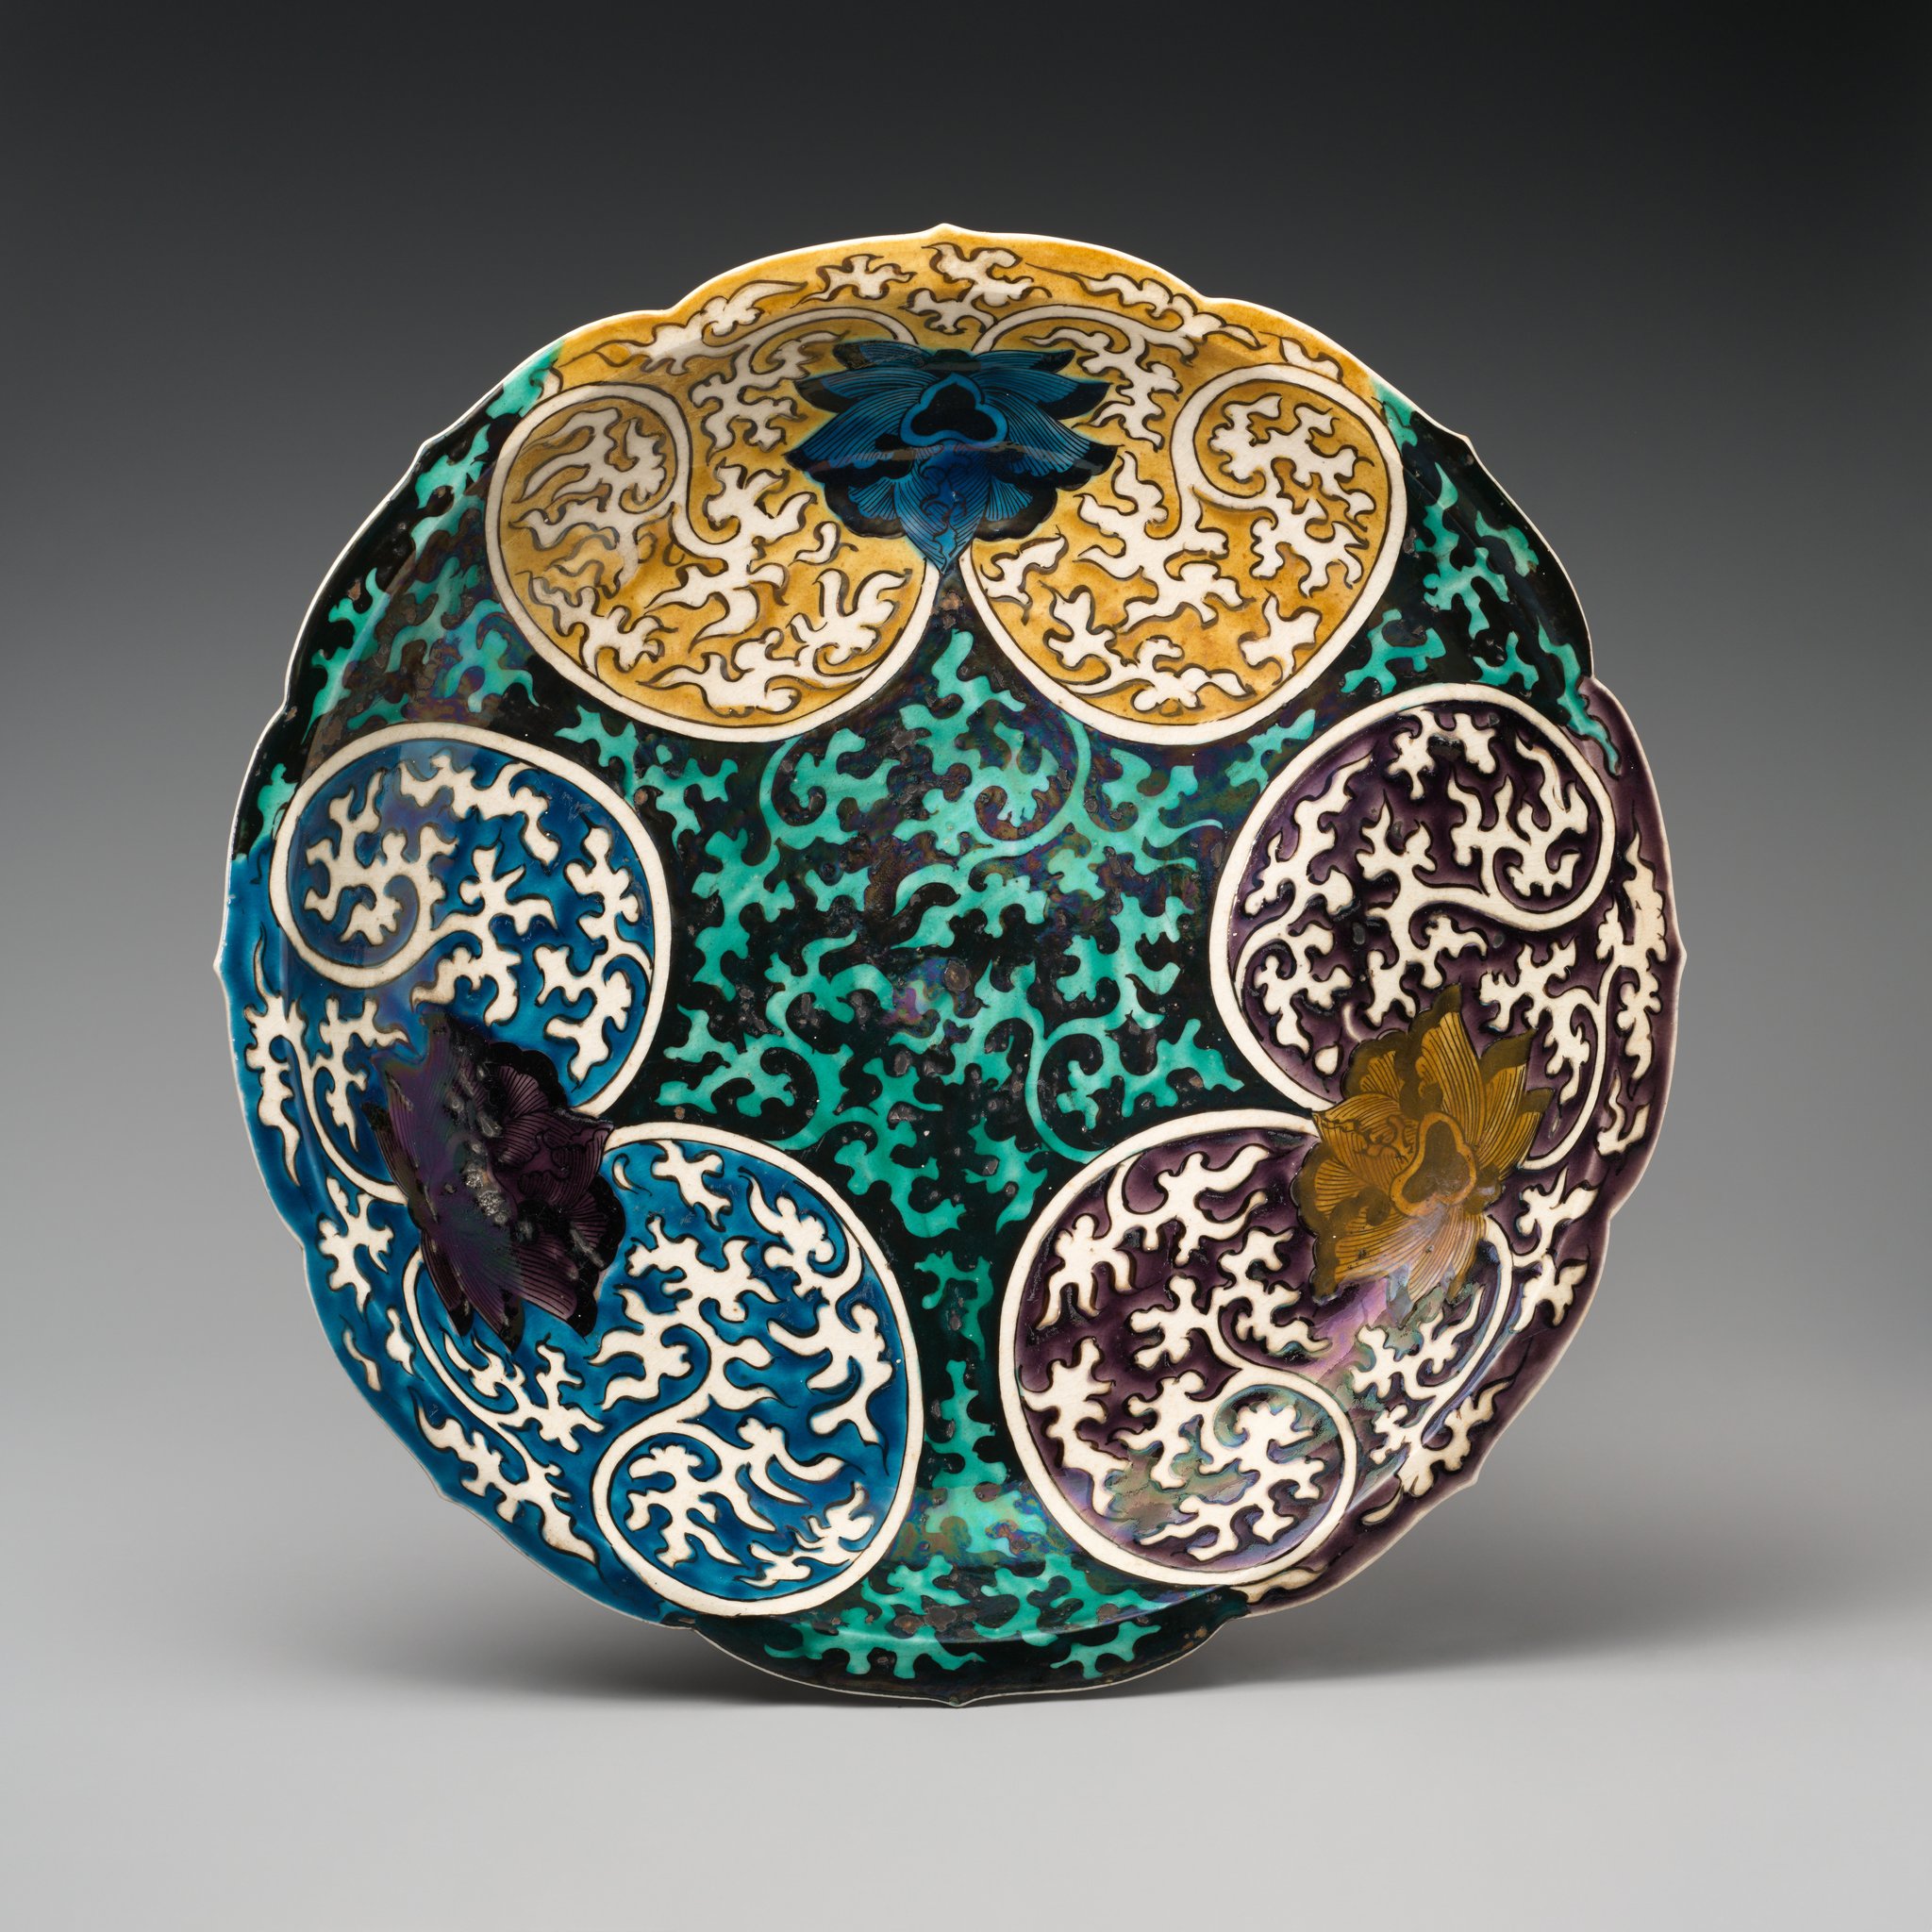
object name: plate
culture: japanese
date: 1850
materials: pottery